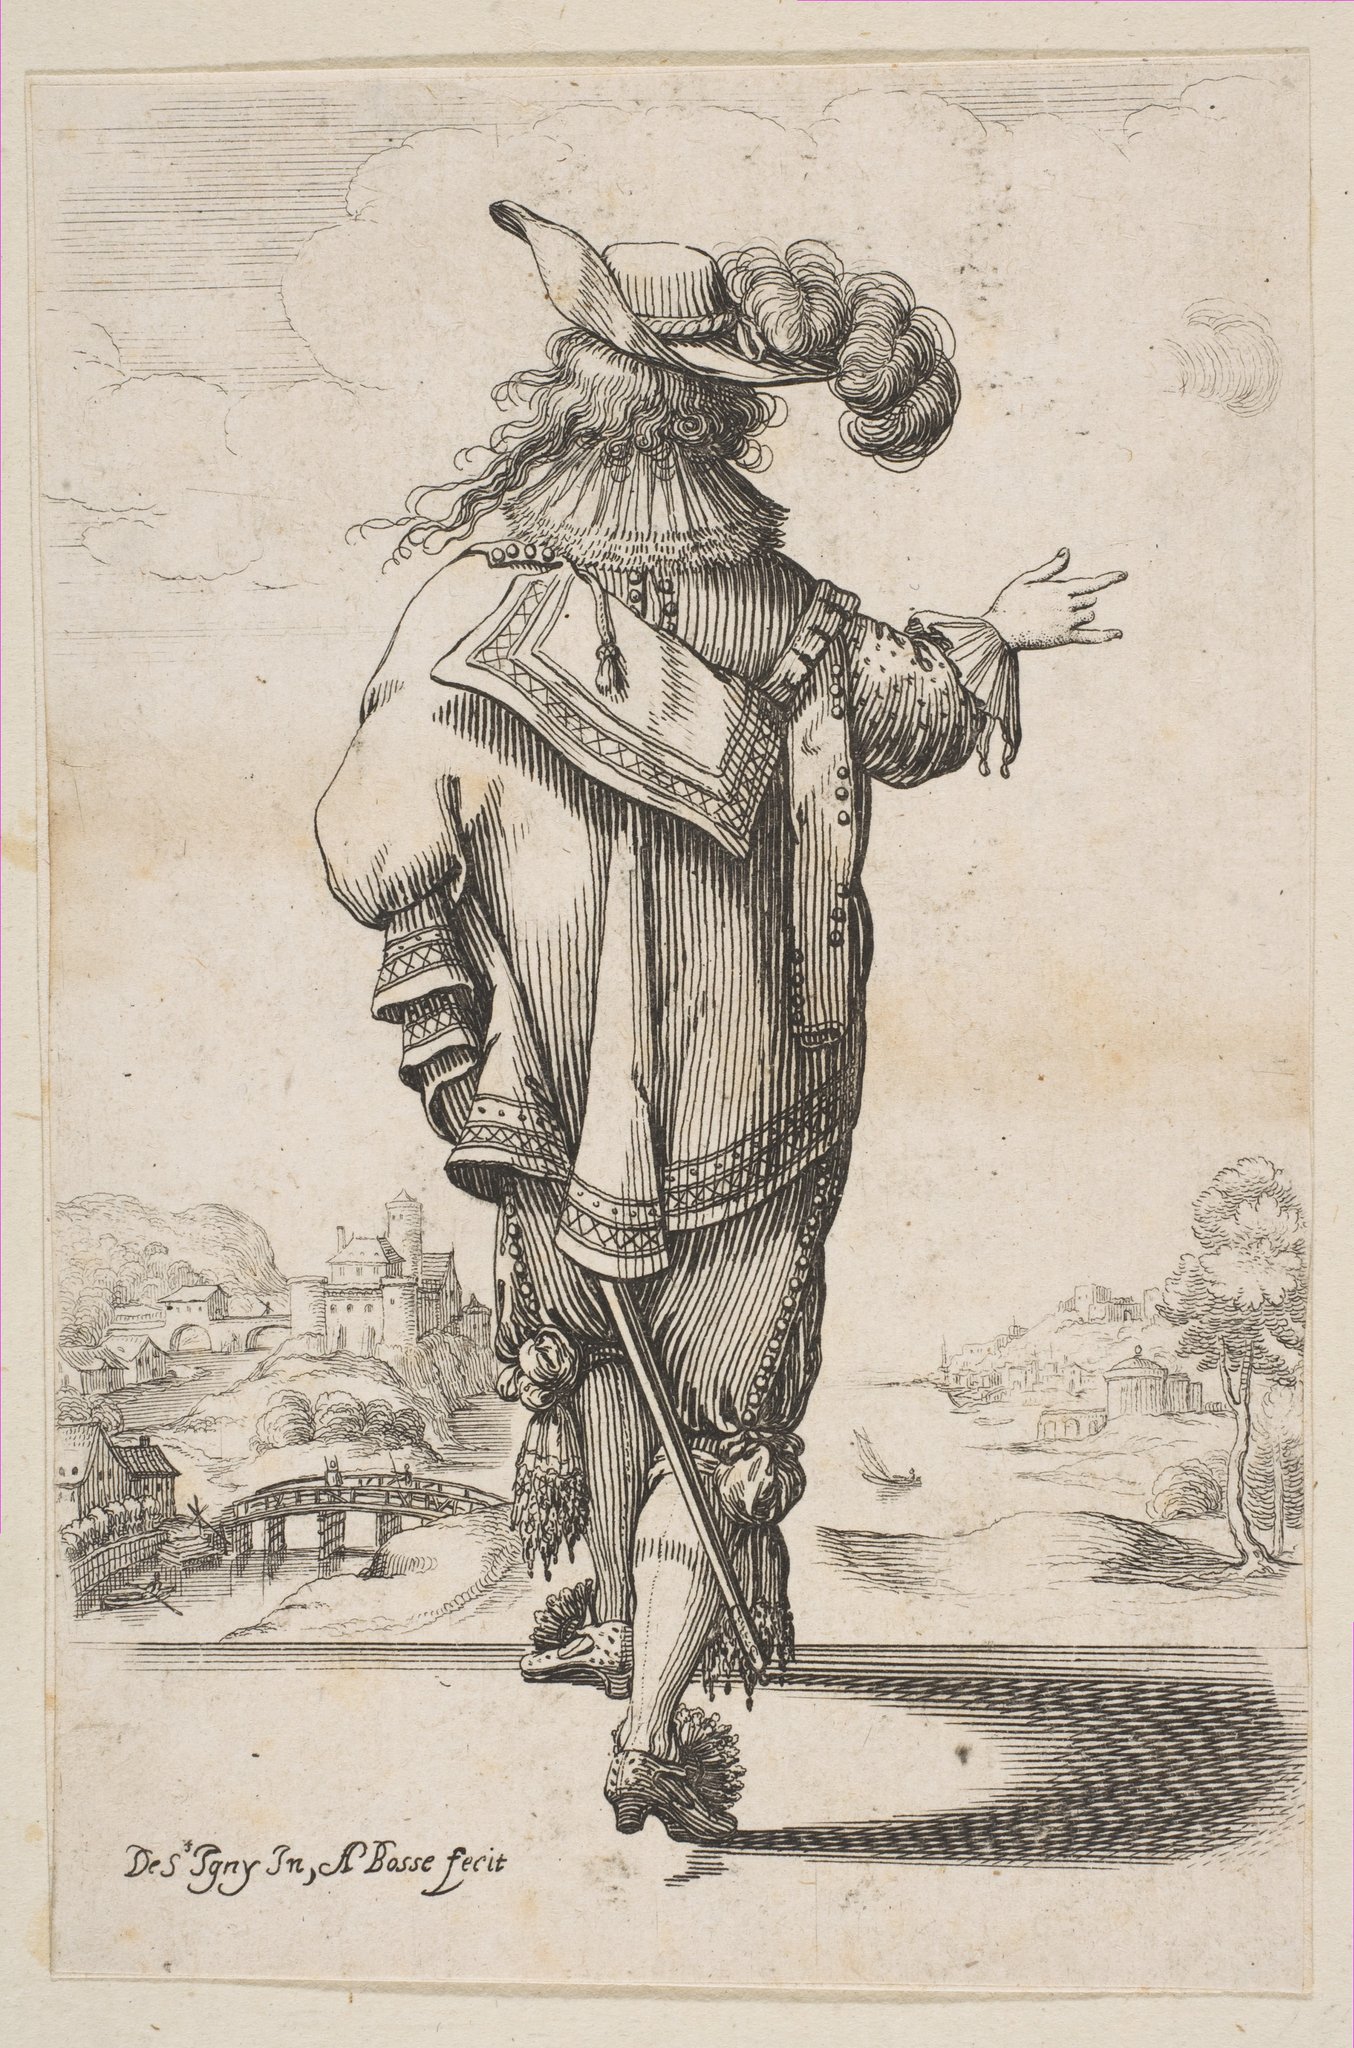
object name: print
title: Gentleman Seen from the Back Indicating a Landscape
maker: abraham bosse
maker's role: artist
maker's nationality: french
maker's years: 1602-1676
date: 1629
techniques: etching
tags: men,landscapes